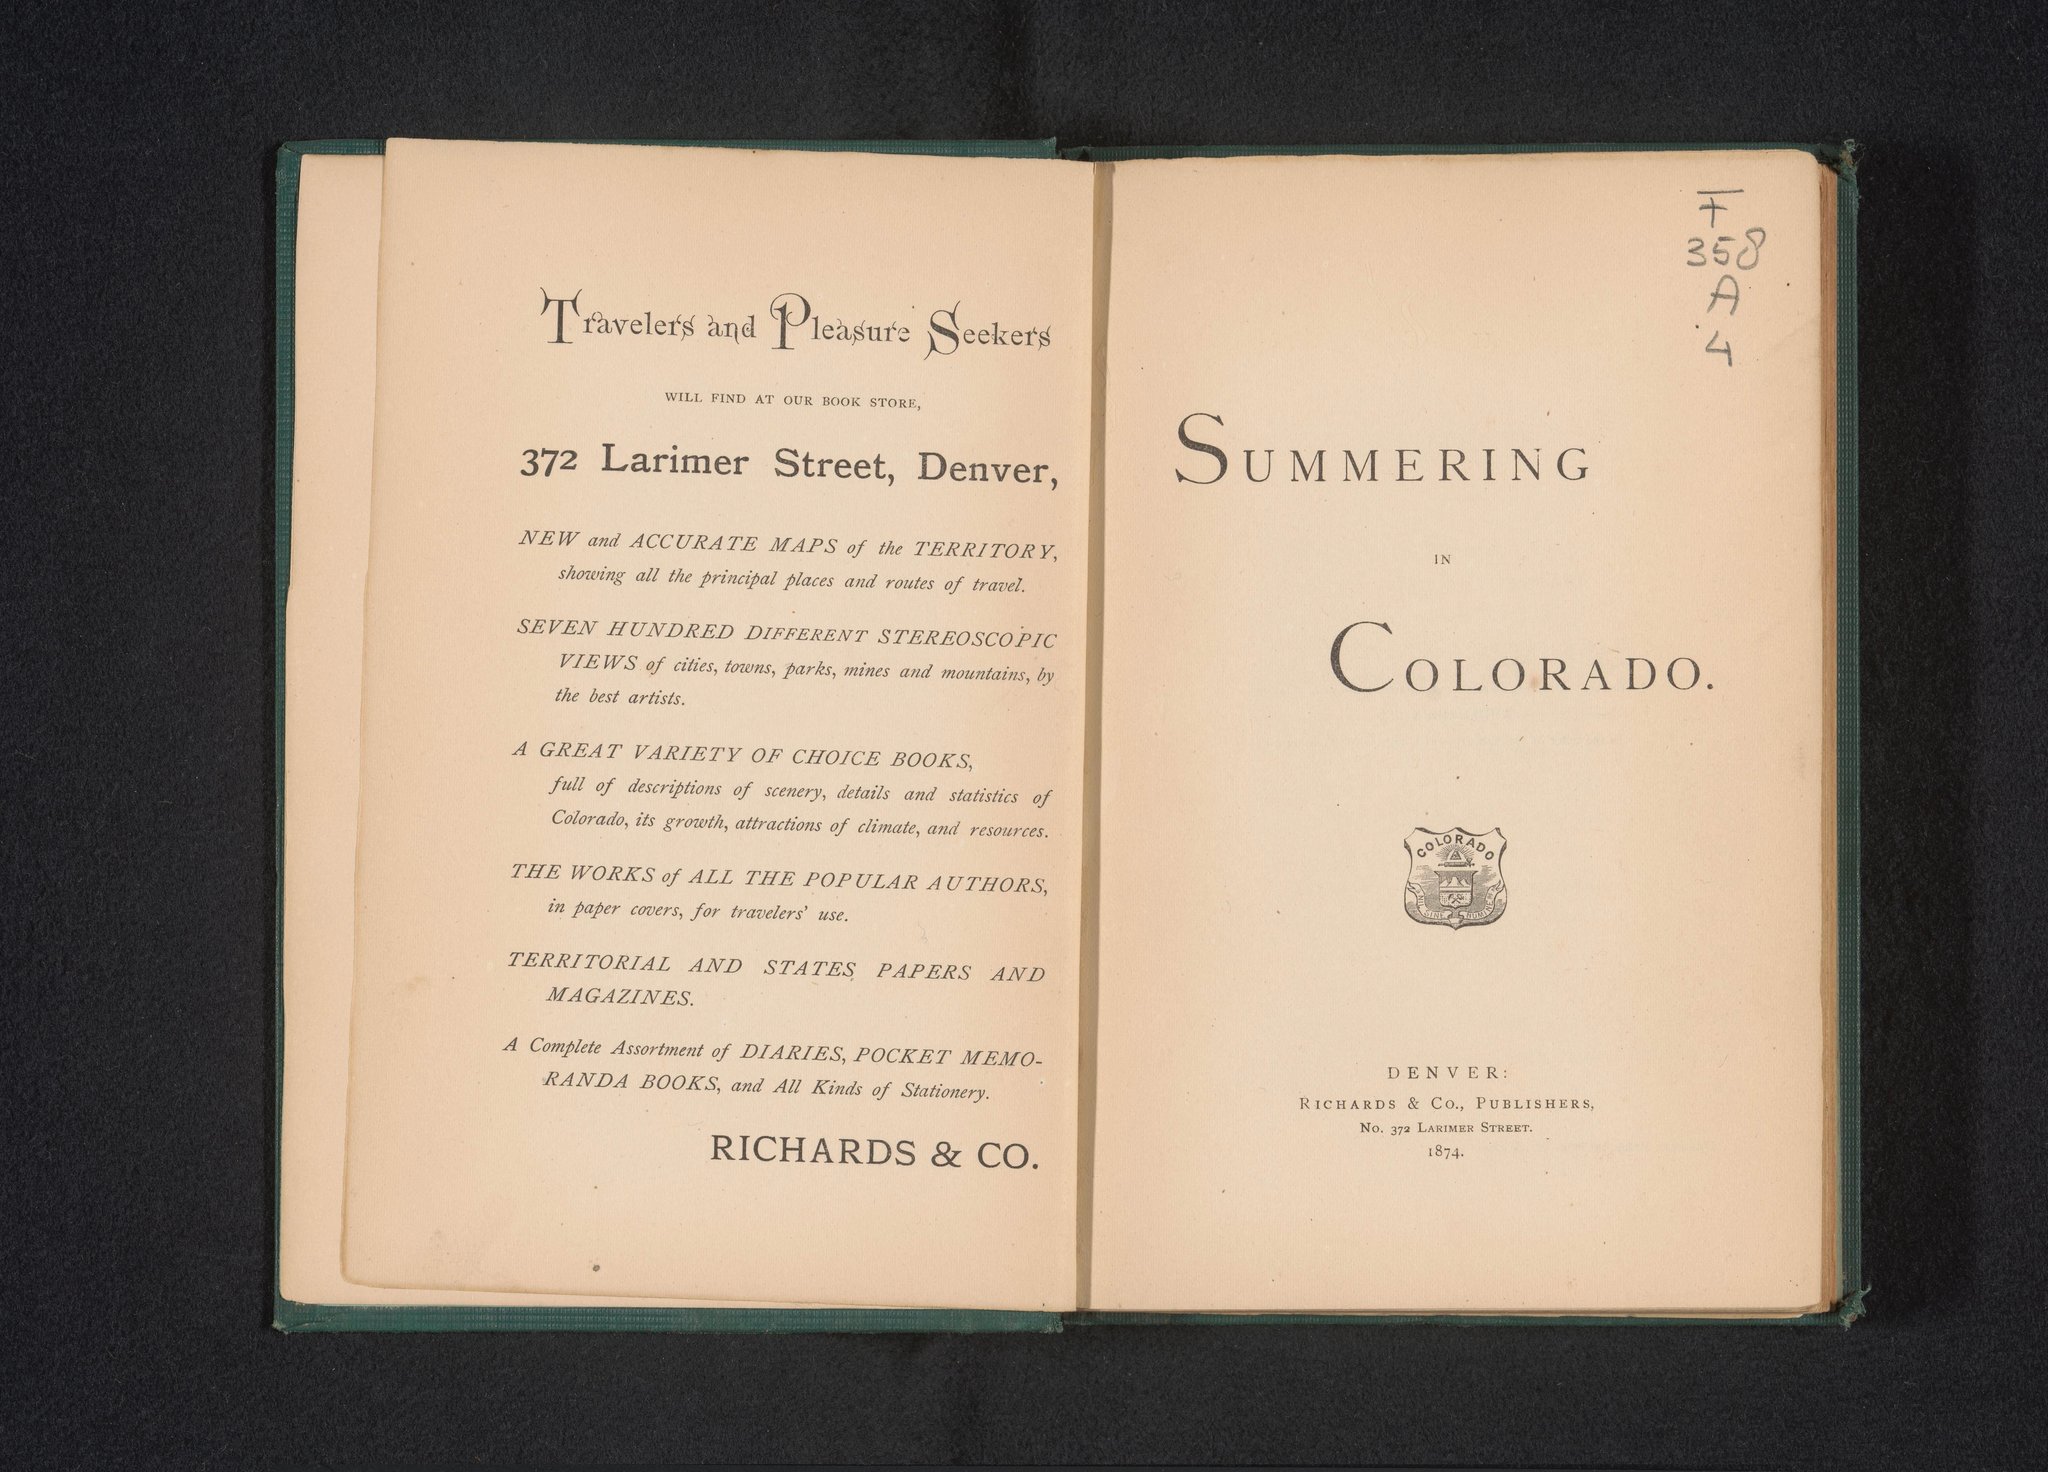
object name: book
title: Summering in Colorado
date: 1874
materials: linen, paper, photographic support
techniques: albumen print, printing, engraving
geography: denver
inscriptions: date: ‘Oct 1992’, annotation: ‘14 tipped in / cc. 6-3-91’